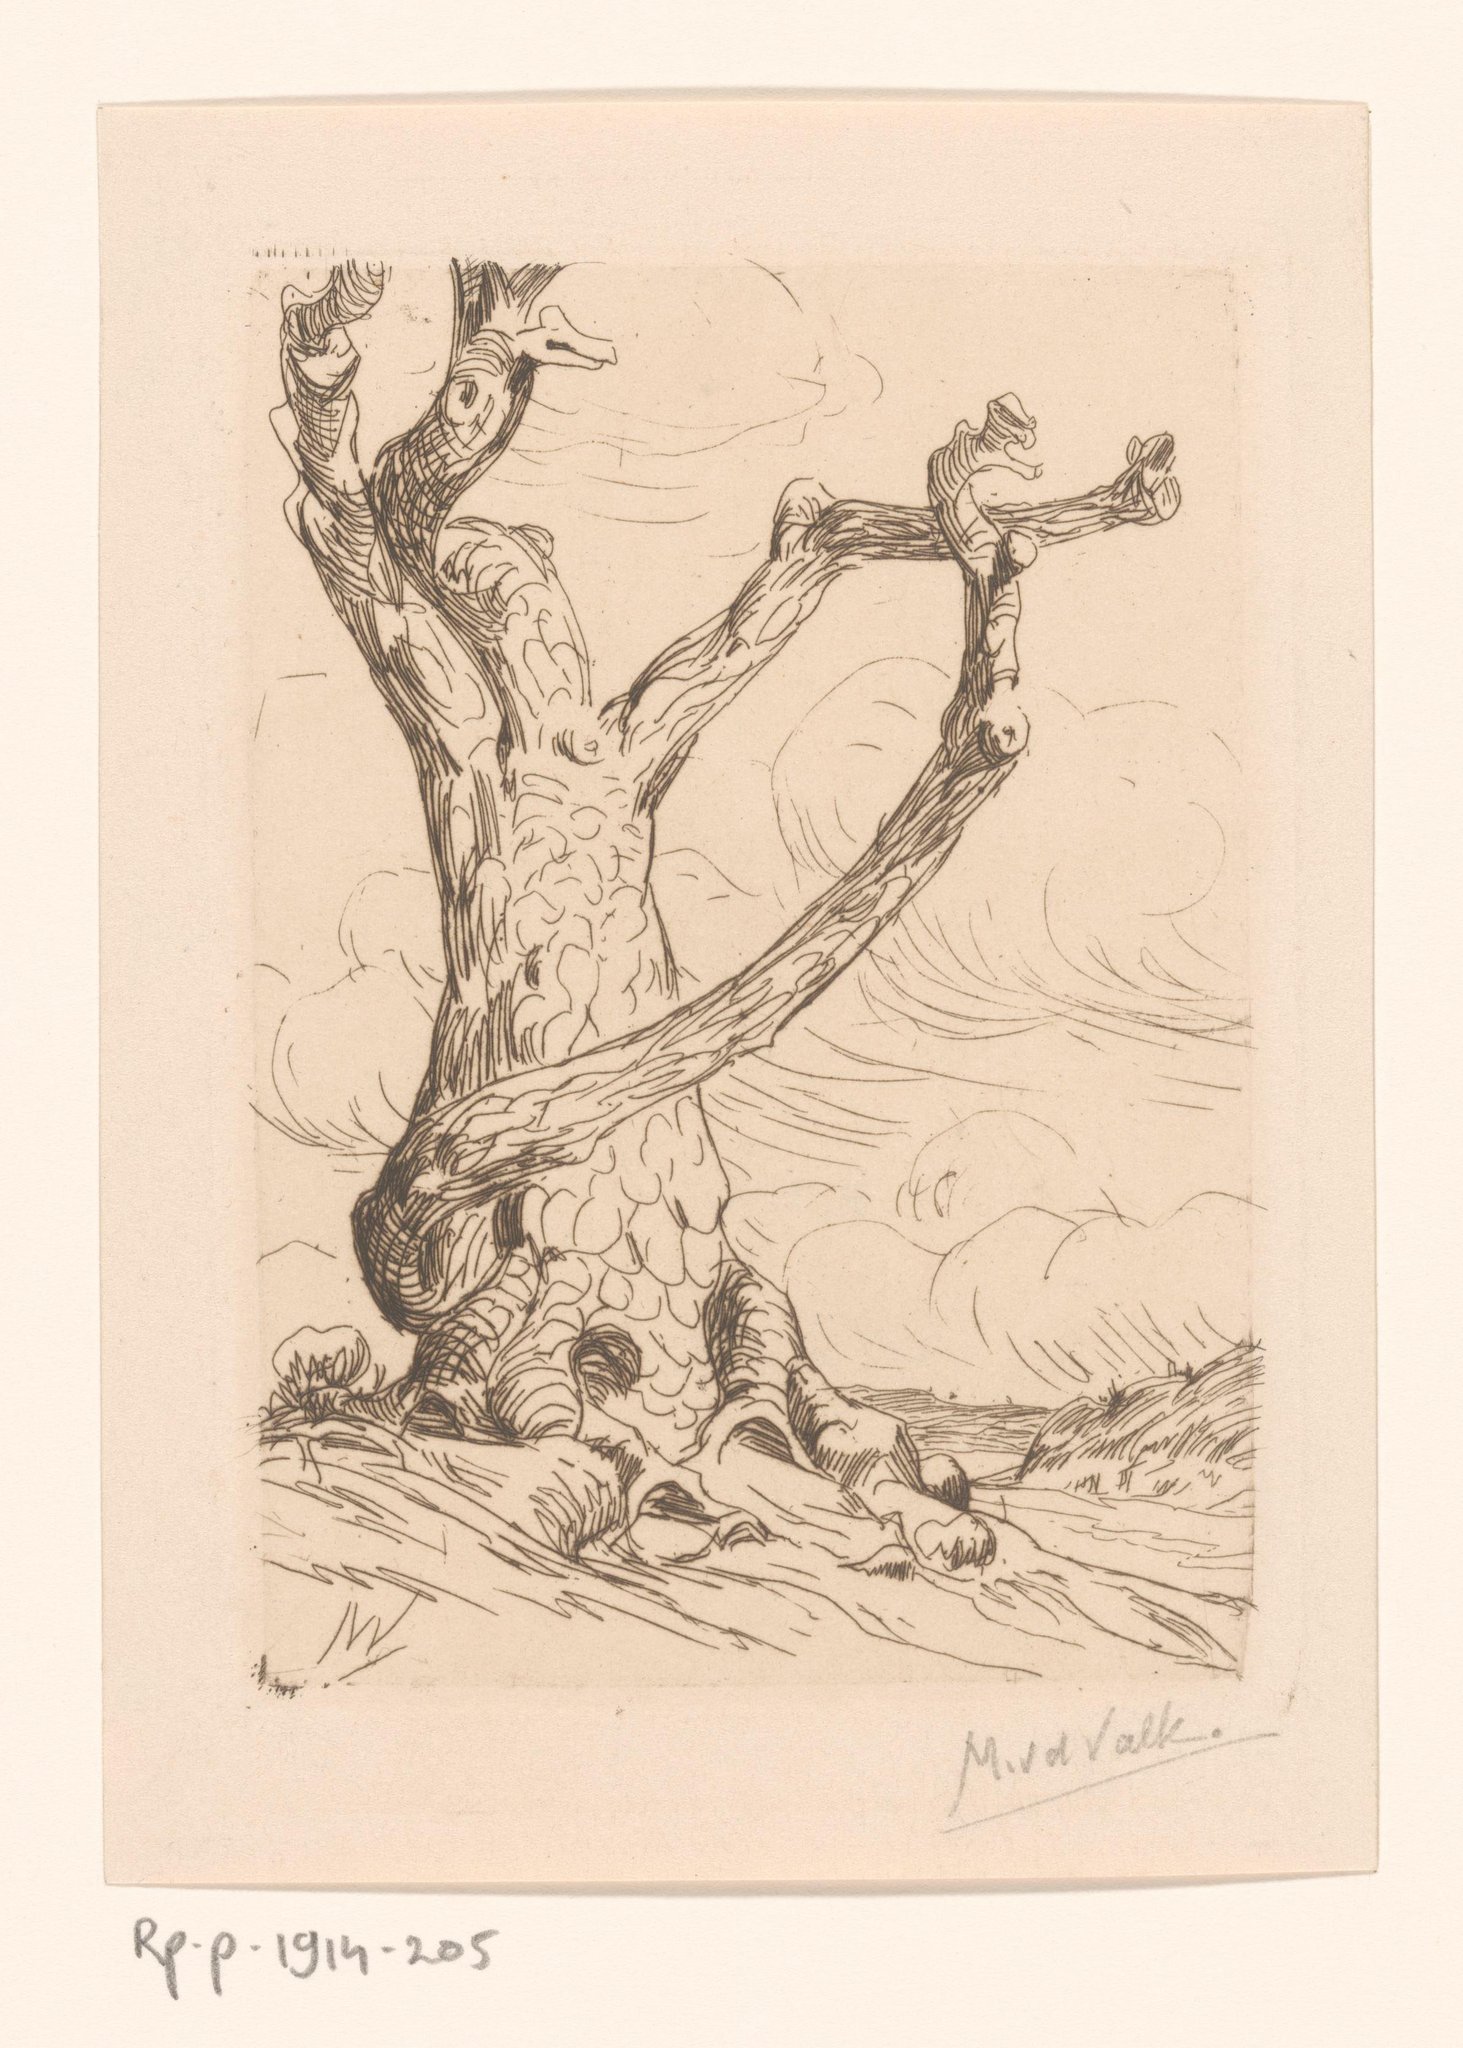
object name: print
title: Wonderboom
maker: maurits van der valk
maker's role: draughtsman, print maker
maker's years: 1857-1935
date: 1867-1914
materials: paper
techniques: etching, intaglio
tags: trees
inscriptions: collector's mark: Lugt 2228